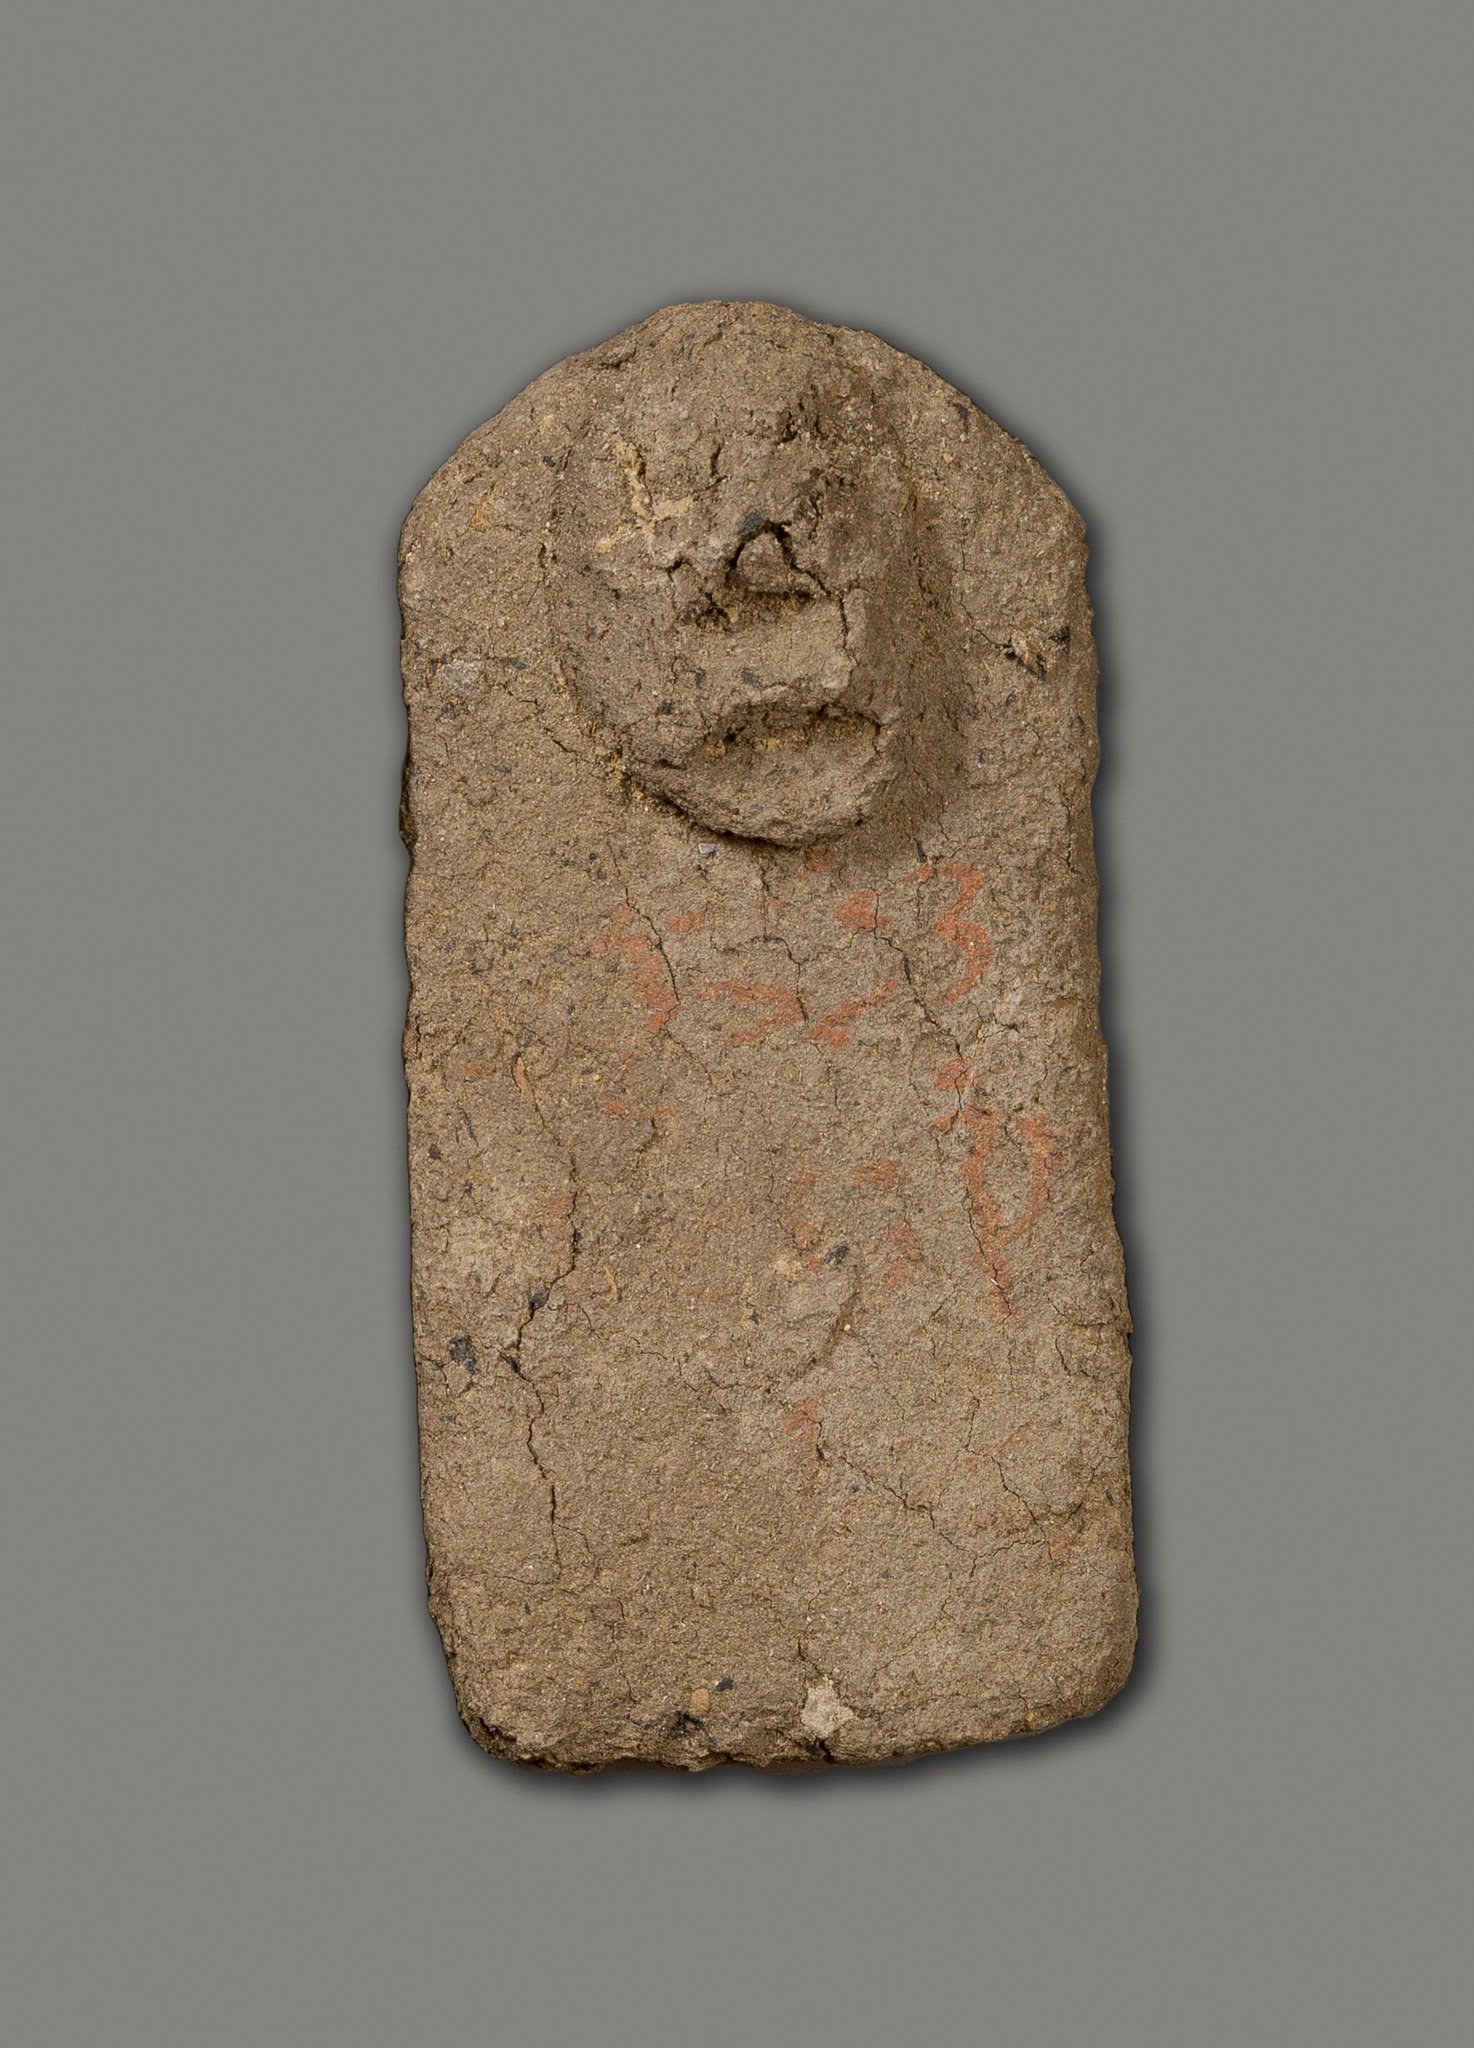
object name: figure, magical, execration, tablet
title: Magical Figure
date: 1802-1550 BCE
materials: clay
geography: egypt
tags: faces